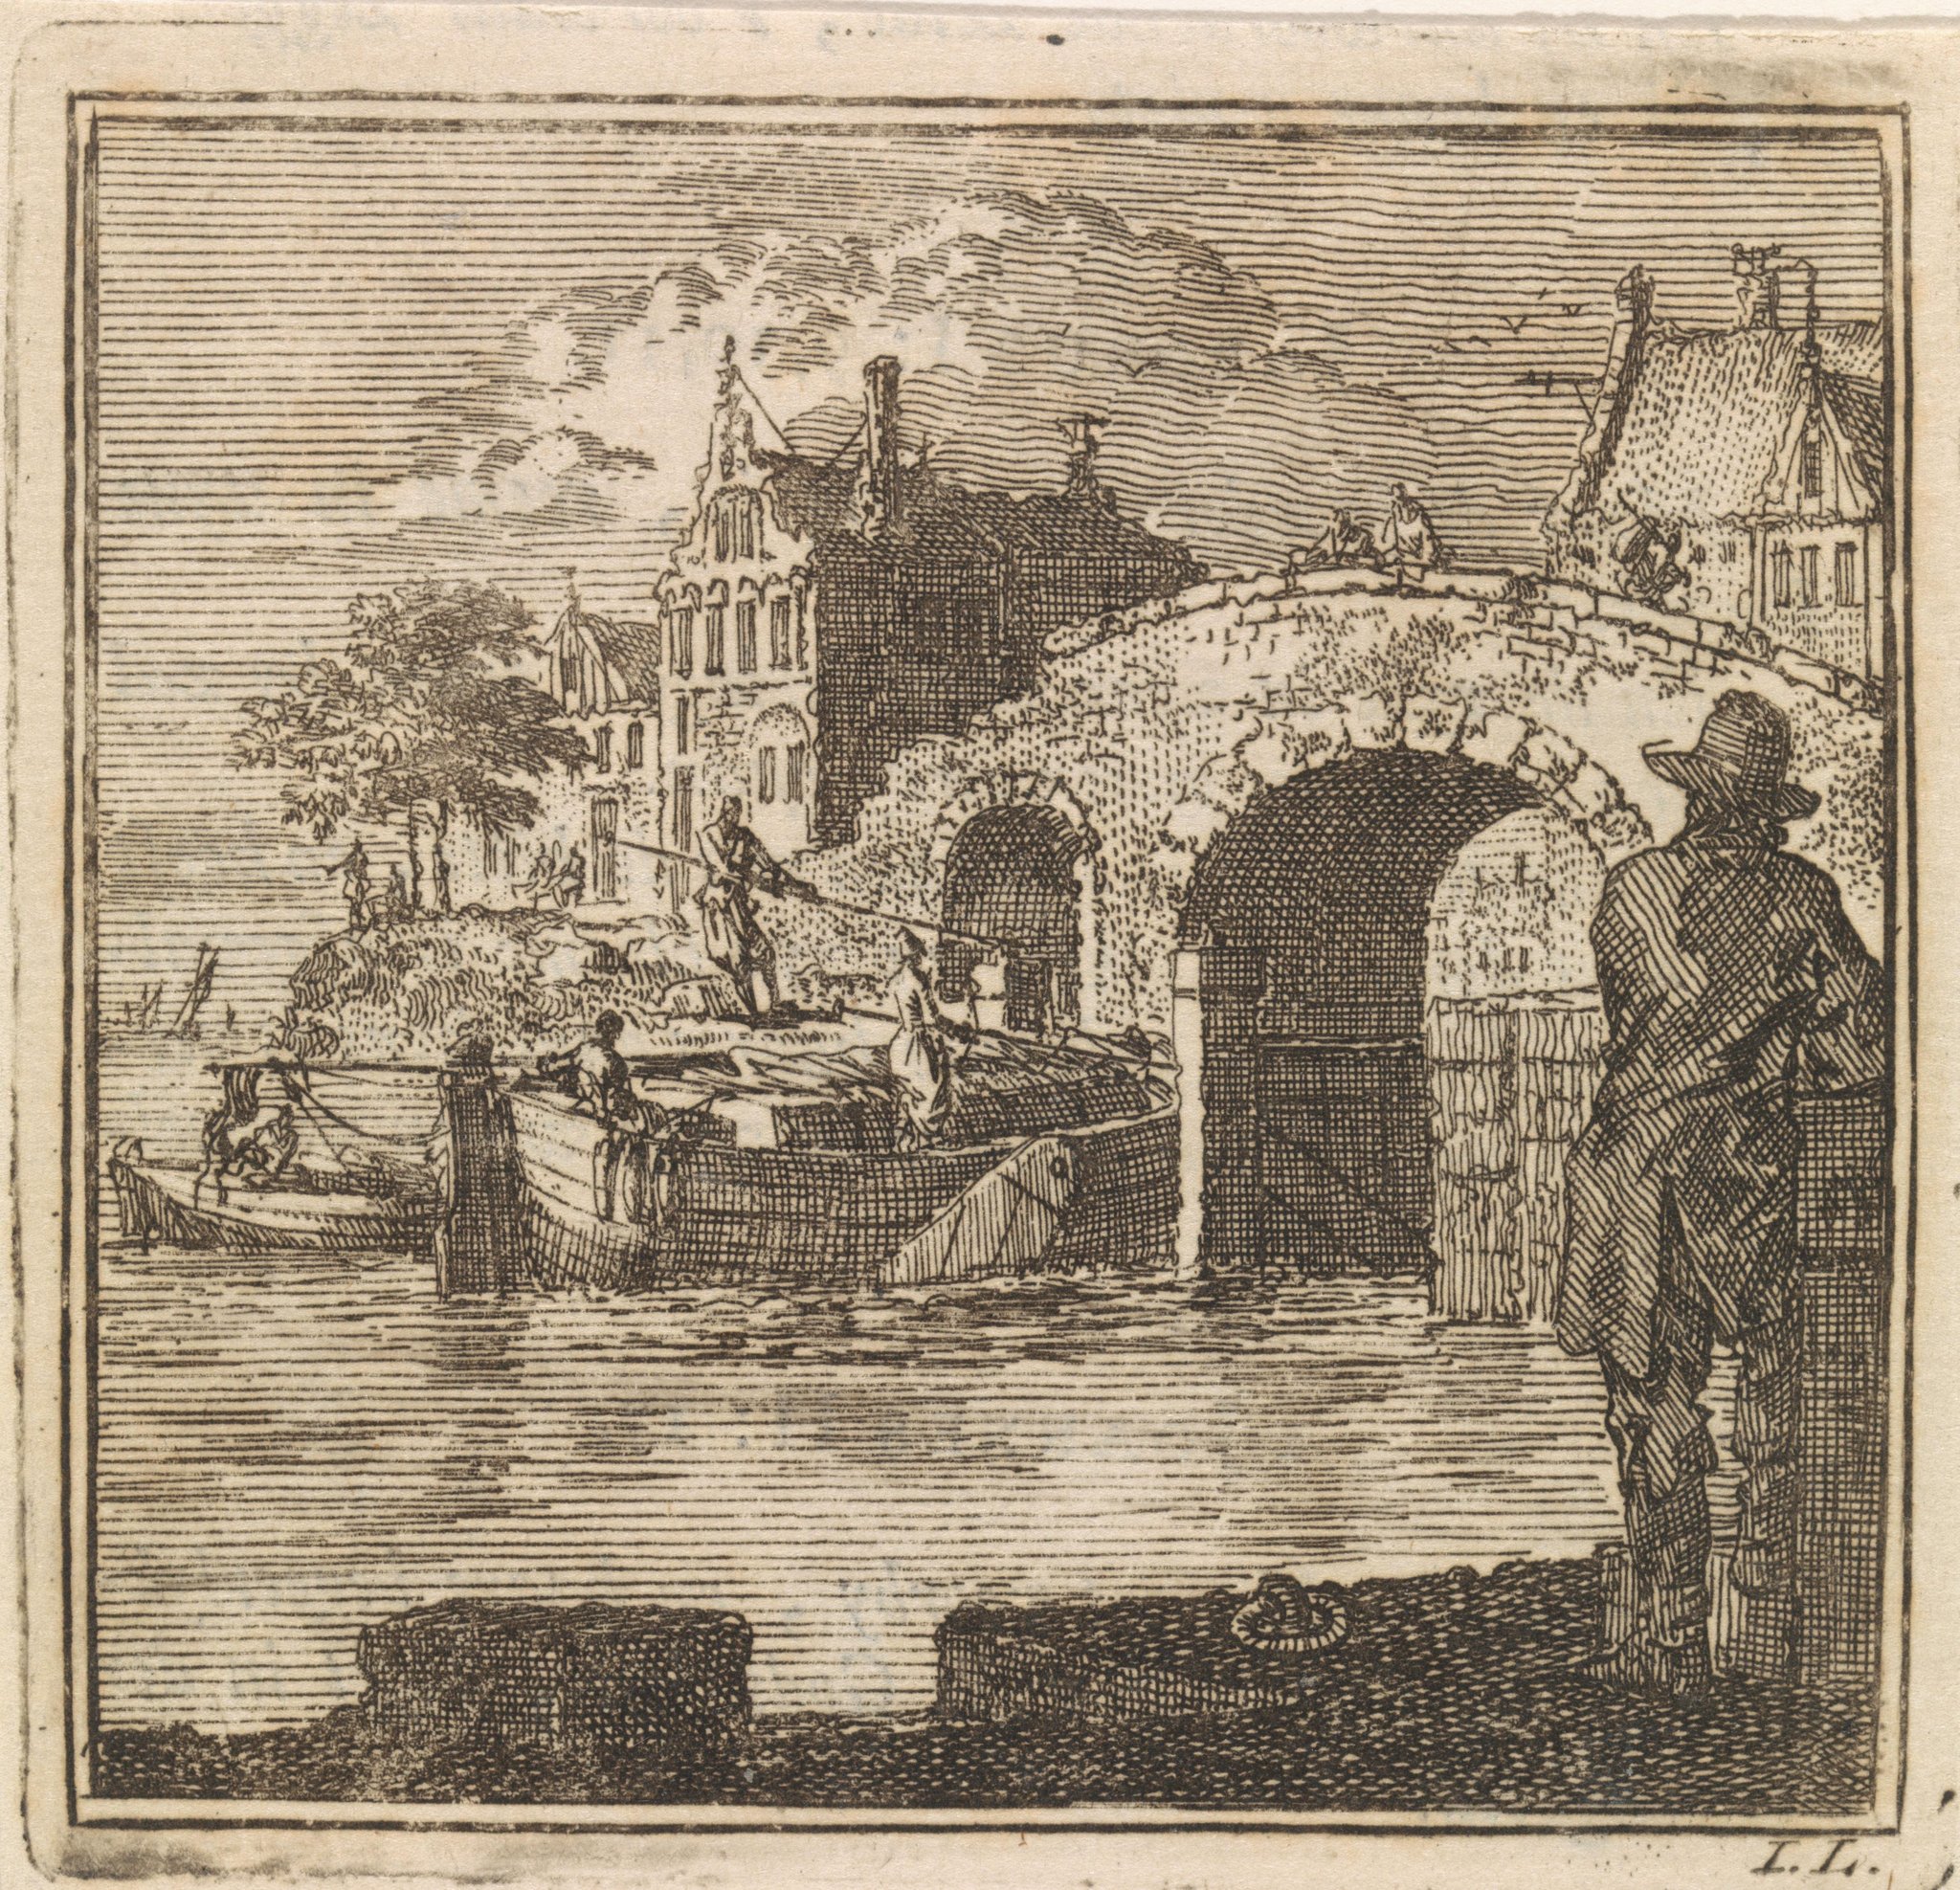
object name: print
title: De Schutsluis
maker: jan luyken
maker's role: draughtsman, print maker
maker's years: 1649-1712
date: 1711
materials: paper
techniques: etching, letterpress printing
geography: amsterdam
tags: sluice, weir, sailing-ship, sailing-boat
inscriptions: collector's mark: Lugt 2228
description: Illustratie voor: Luyken, Jan. De Bykorf des Gemoeds. Amsterdam: Pieter Arentsz. II (wed.) en Cornelis van der Sys, 1711, p. 386.